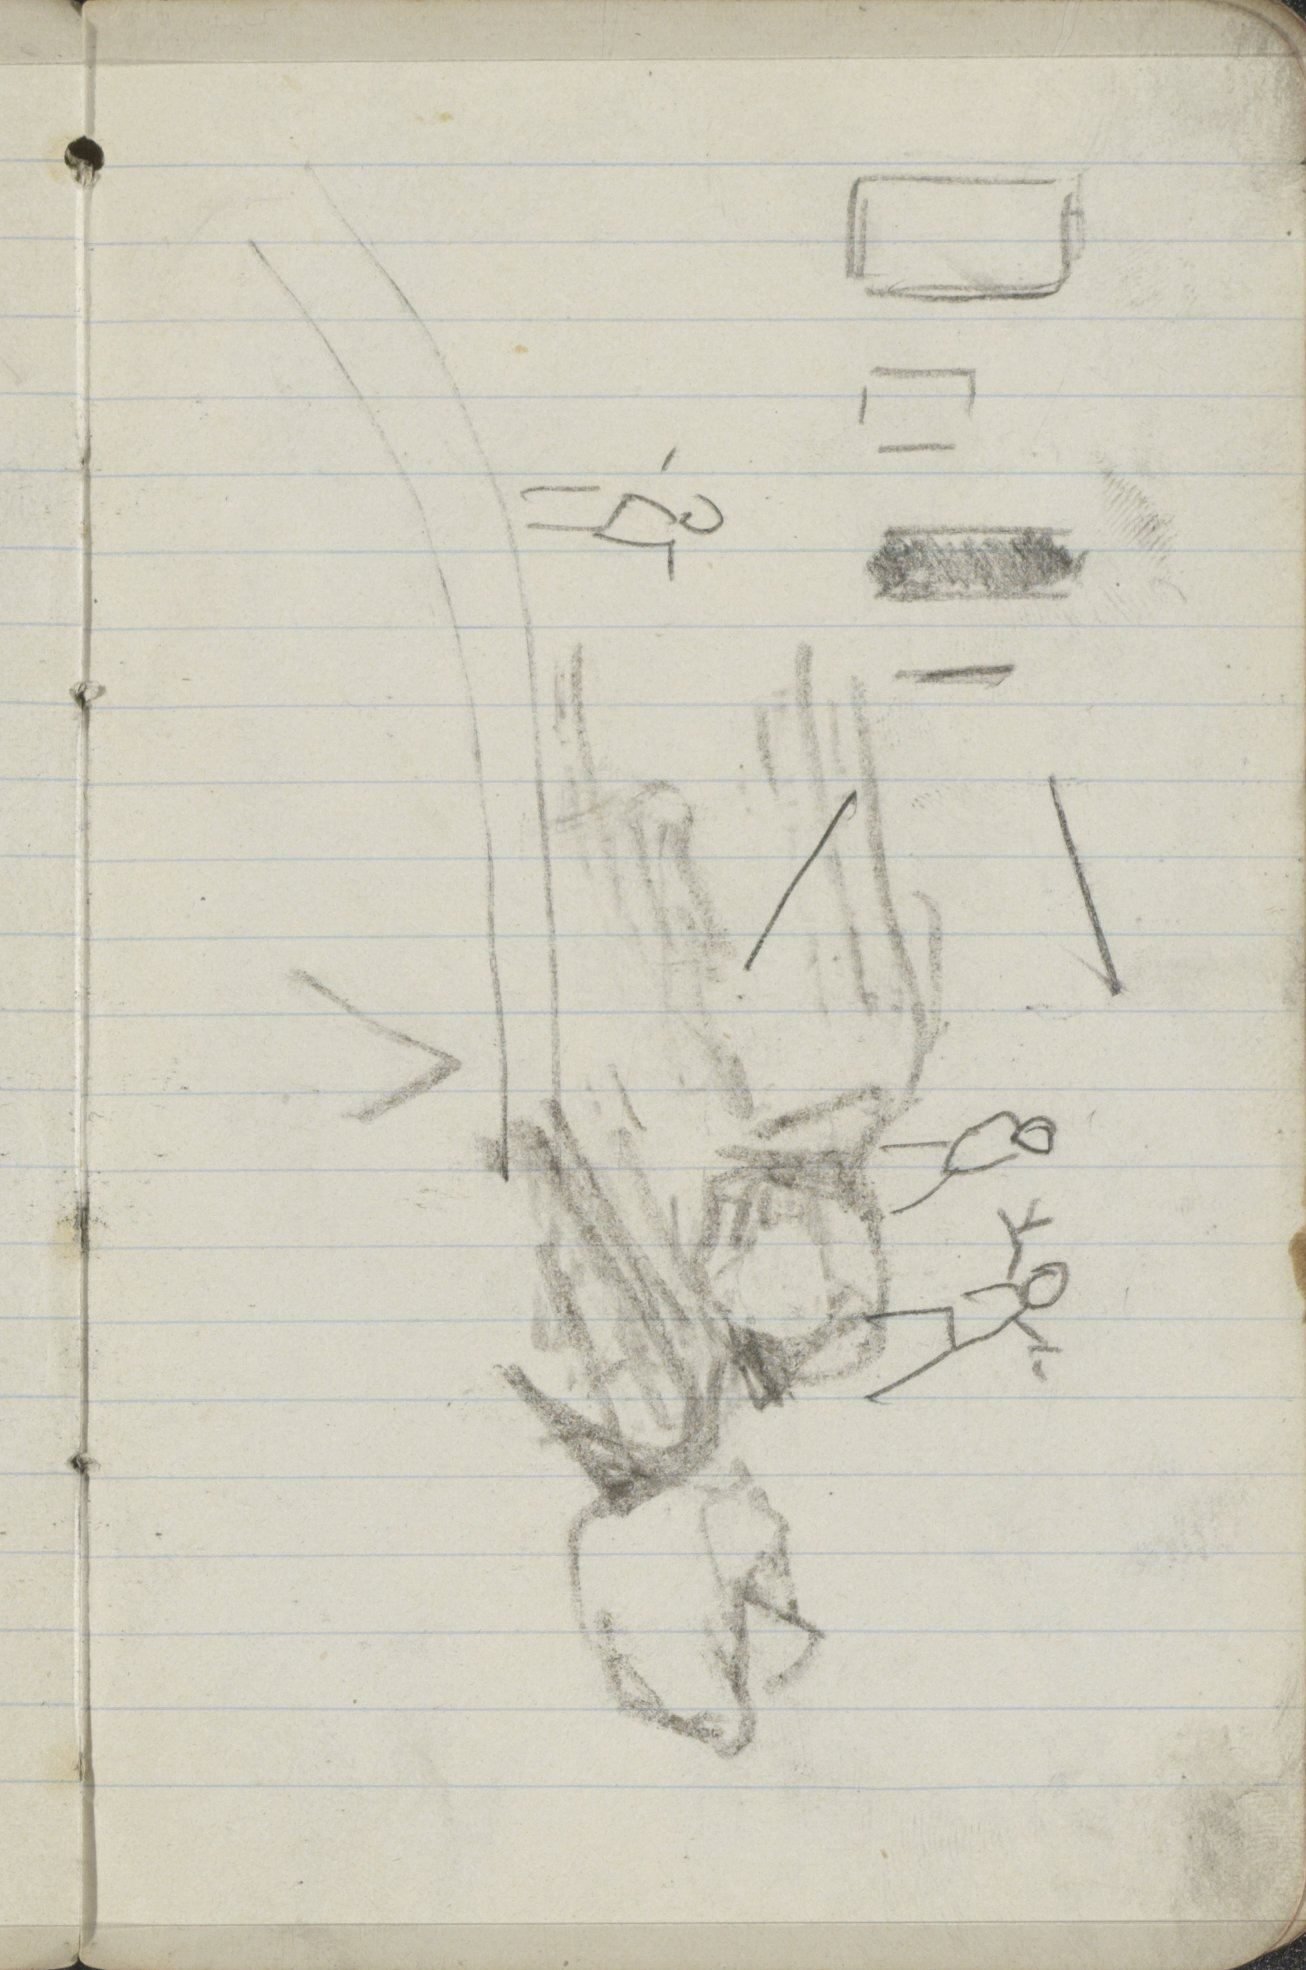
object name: sketchbook leaf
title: Studieblad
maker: george hendrik breitner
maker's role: draughtsman, painter, print maker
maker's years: 1857-1923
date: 1894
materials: chalk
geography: amsterdam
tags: window, city-view, and landscape with man-made constructions (+ city(-scape) with figures, staffage)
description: Onder andere figuren en mogelijk ramen. Pagina 36 uit een schetsboek met 31 bladen.